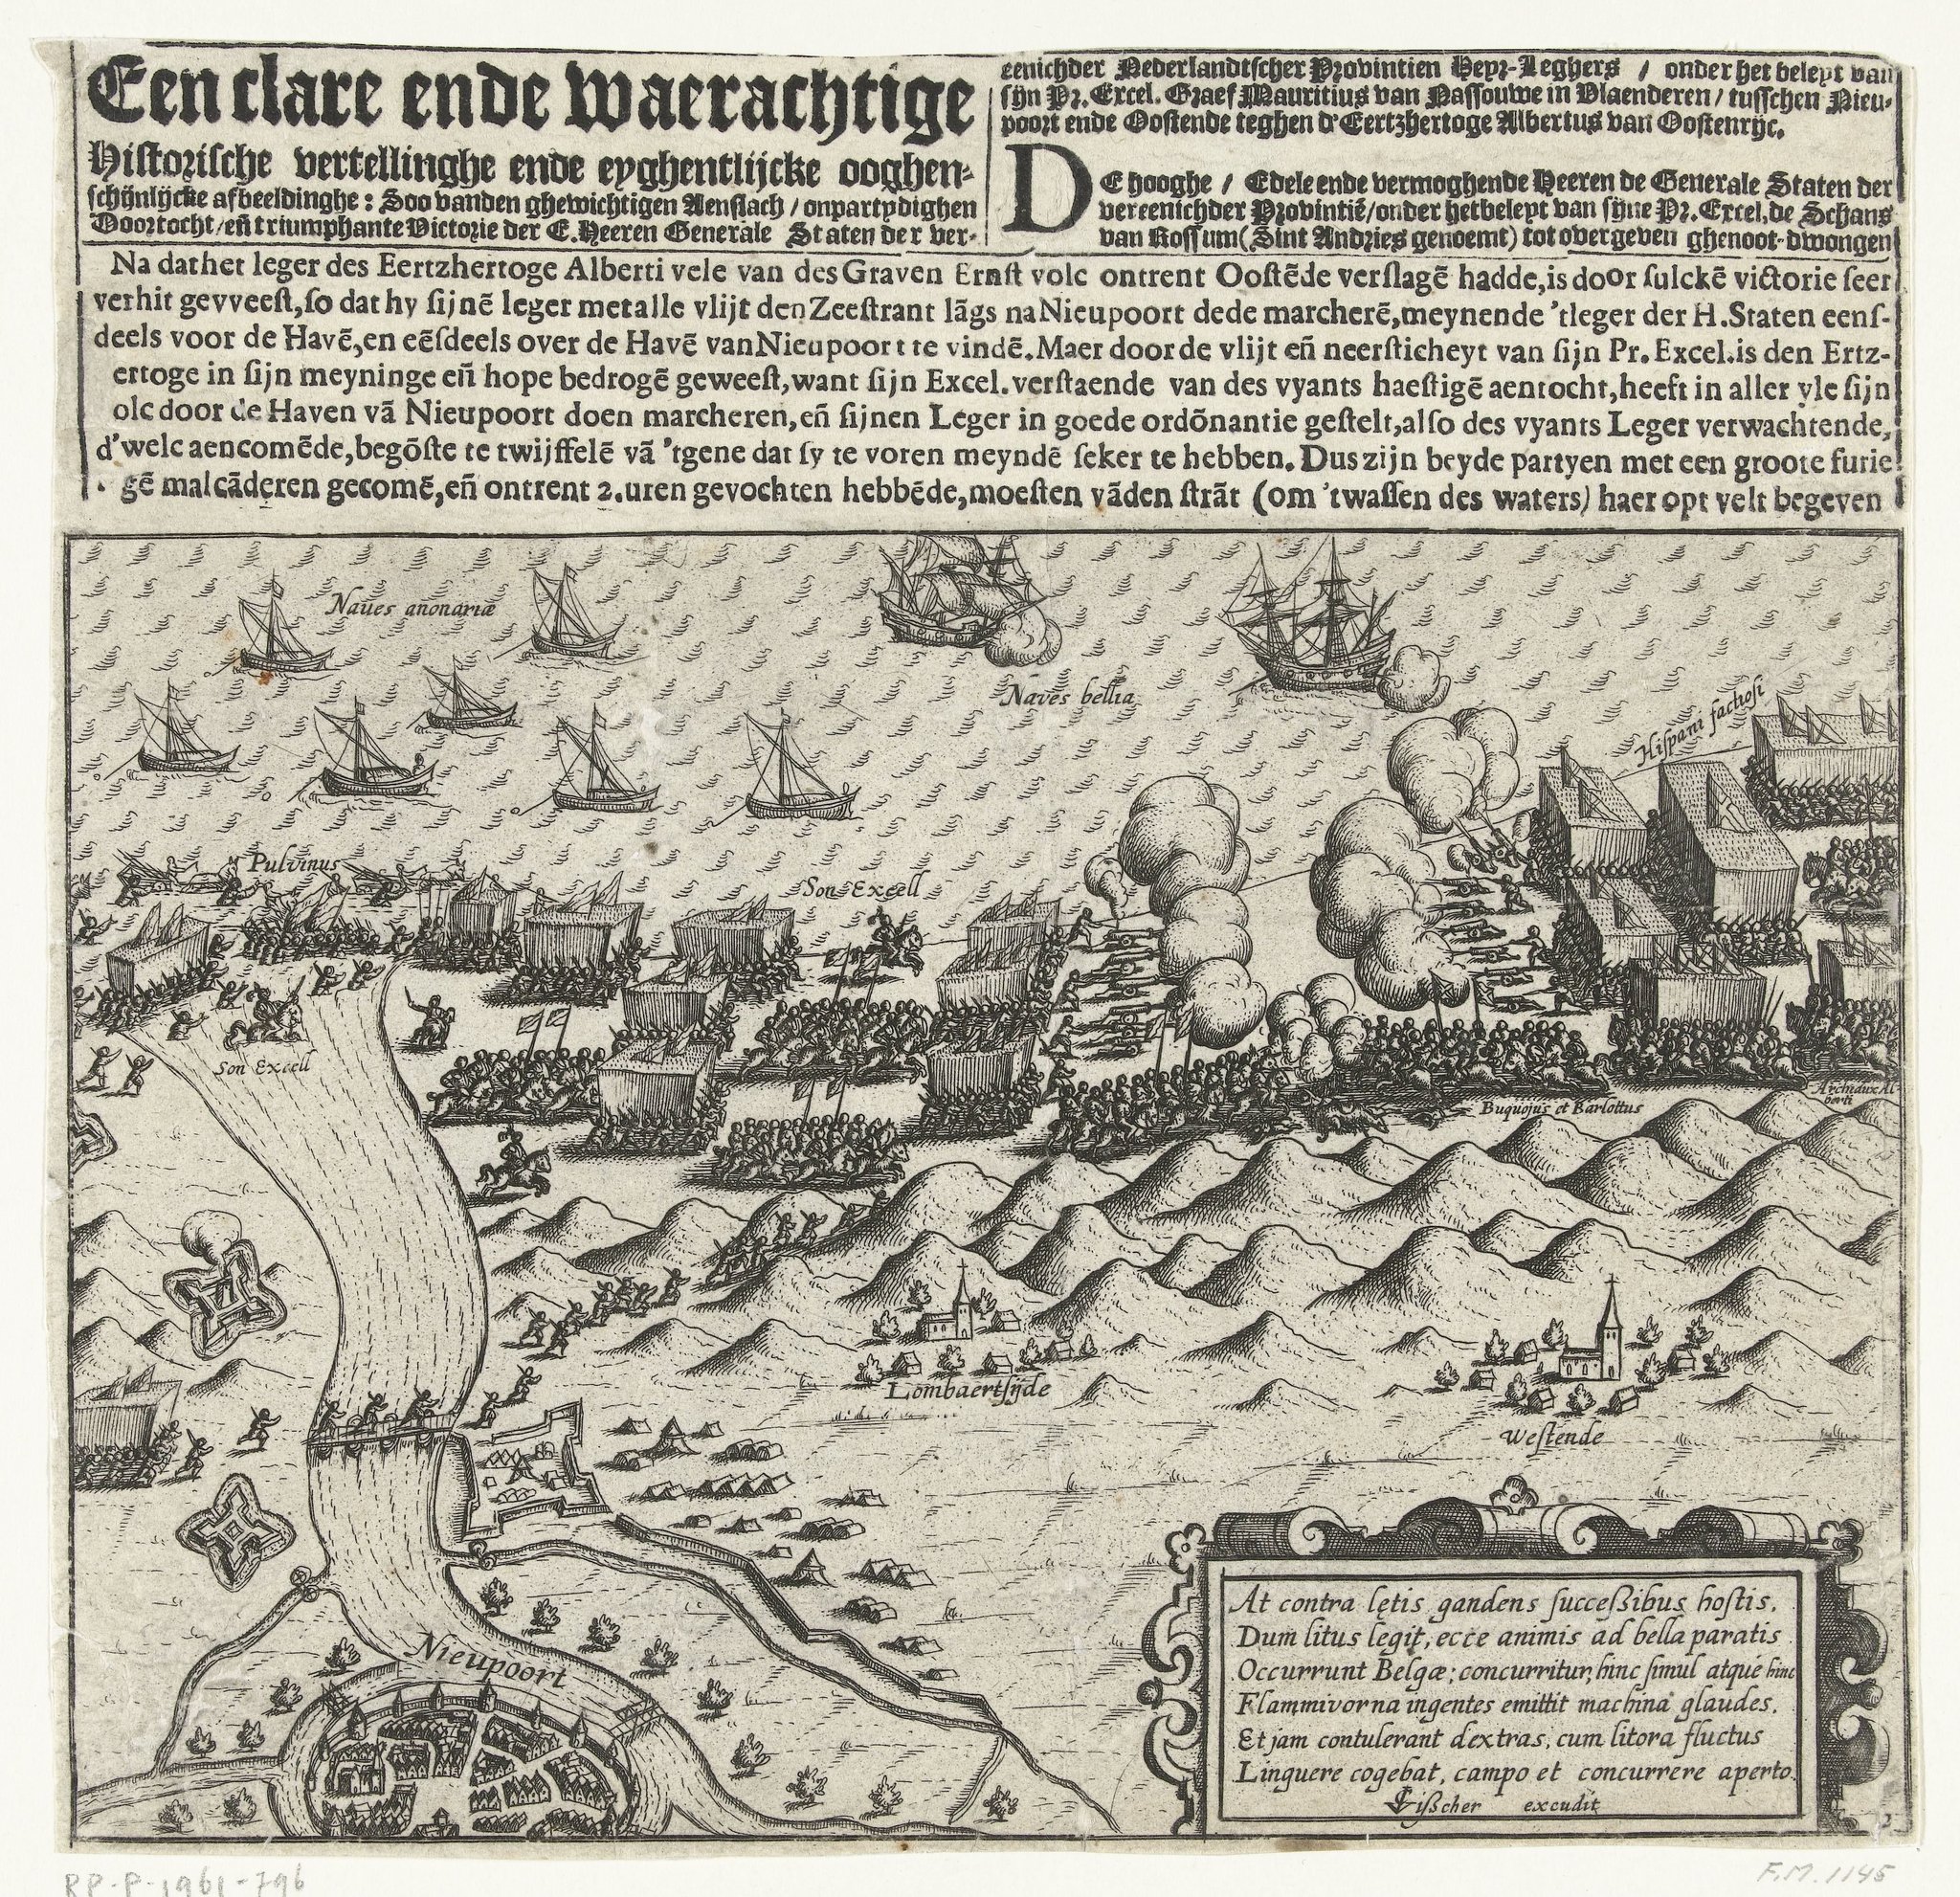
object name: print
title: Een clare ende waerachtige historische vertellinghe ende eyghentijcke ooghenschijnlijcke afbeeldinghe (...)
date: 1600-1649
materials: paper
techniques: etching, letterpress printing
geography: northern netherlands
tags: the hague, maurice (prince of orange), albrecht aartshertog van oostenrijk, battle (+ land forces), battle of nieuwpoort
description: De slag bij Nieuwpoort, 2 juli 1600 (plaat 2). De gevechten op het strand tussen het Staatse leger en Spaanse troepen onder Albrecht. In de voorstelling een cartouche met Latijnse tekst; boven de plaat teksten in romeins en gotisch schrift in het Nederlands. De plaat genummerd 2 uit een groep van 4 bladen in een nieuwsbericht over de slag bij Nieuwpoort.